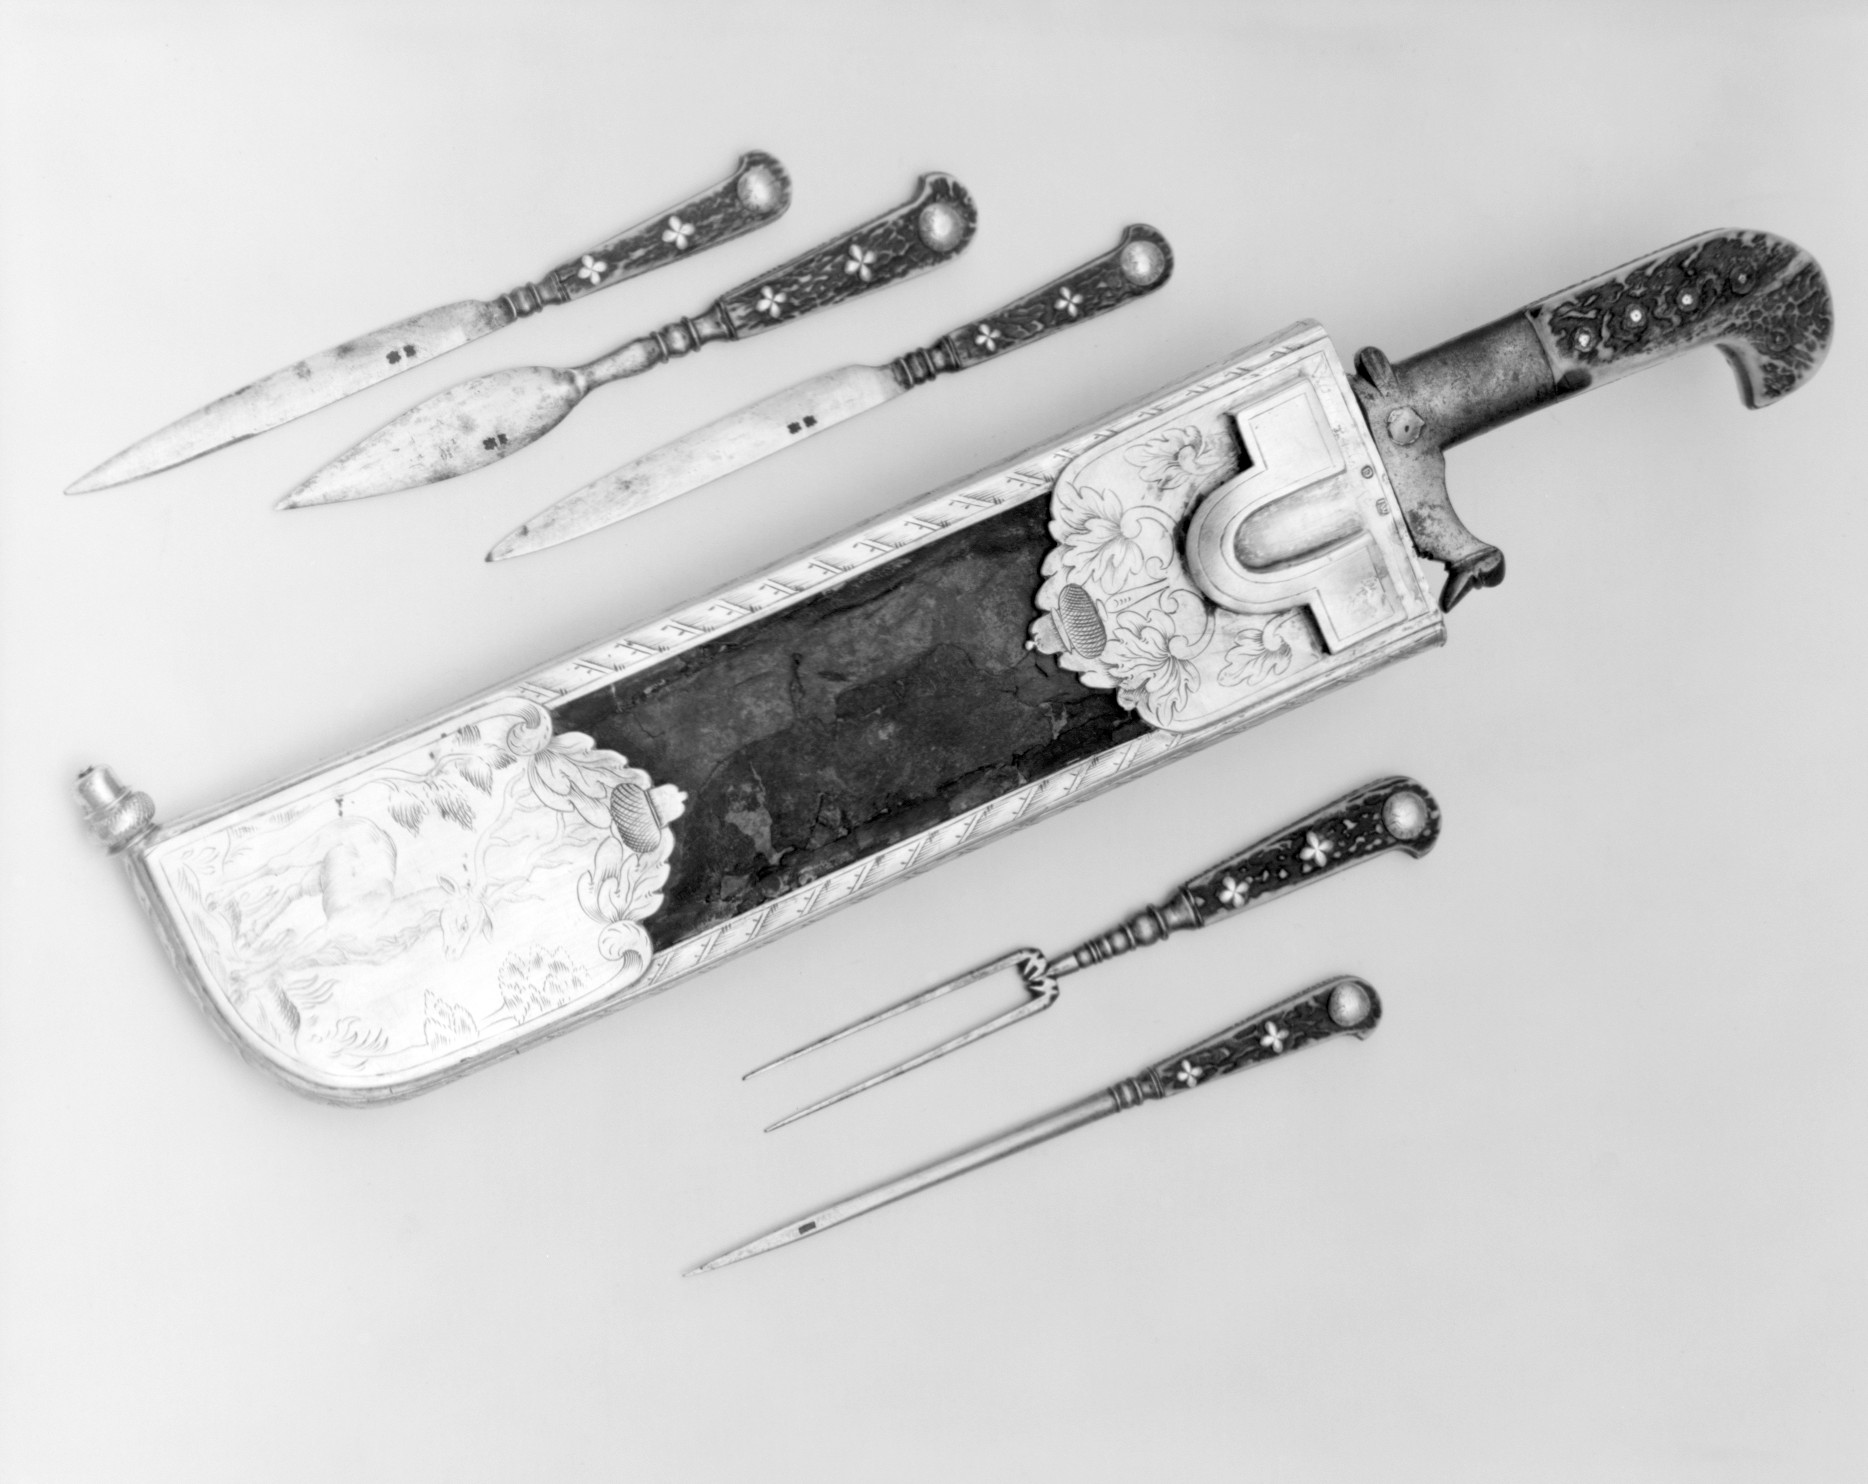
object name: set of hunting implement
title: Set of hunting implements (Trousse)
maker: jakob watzky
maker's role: maker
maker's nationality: german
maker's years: 1641-1679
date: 1650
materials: leather, silver, steel, wood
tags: deer